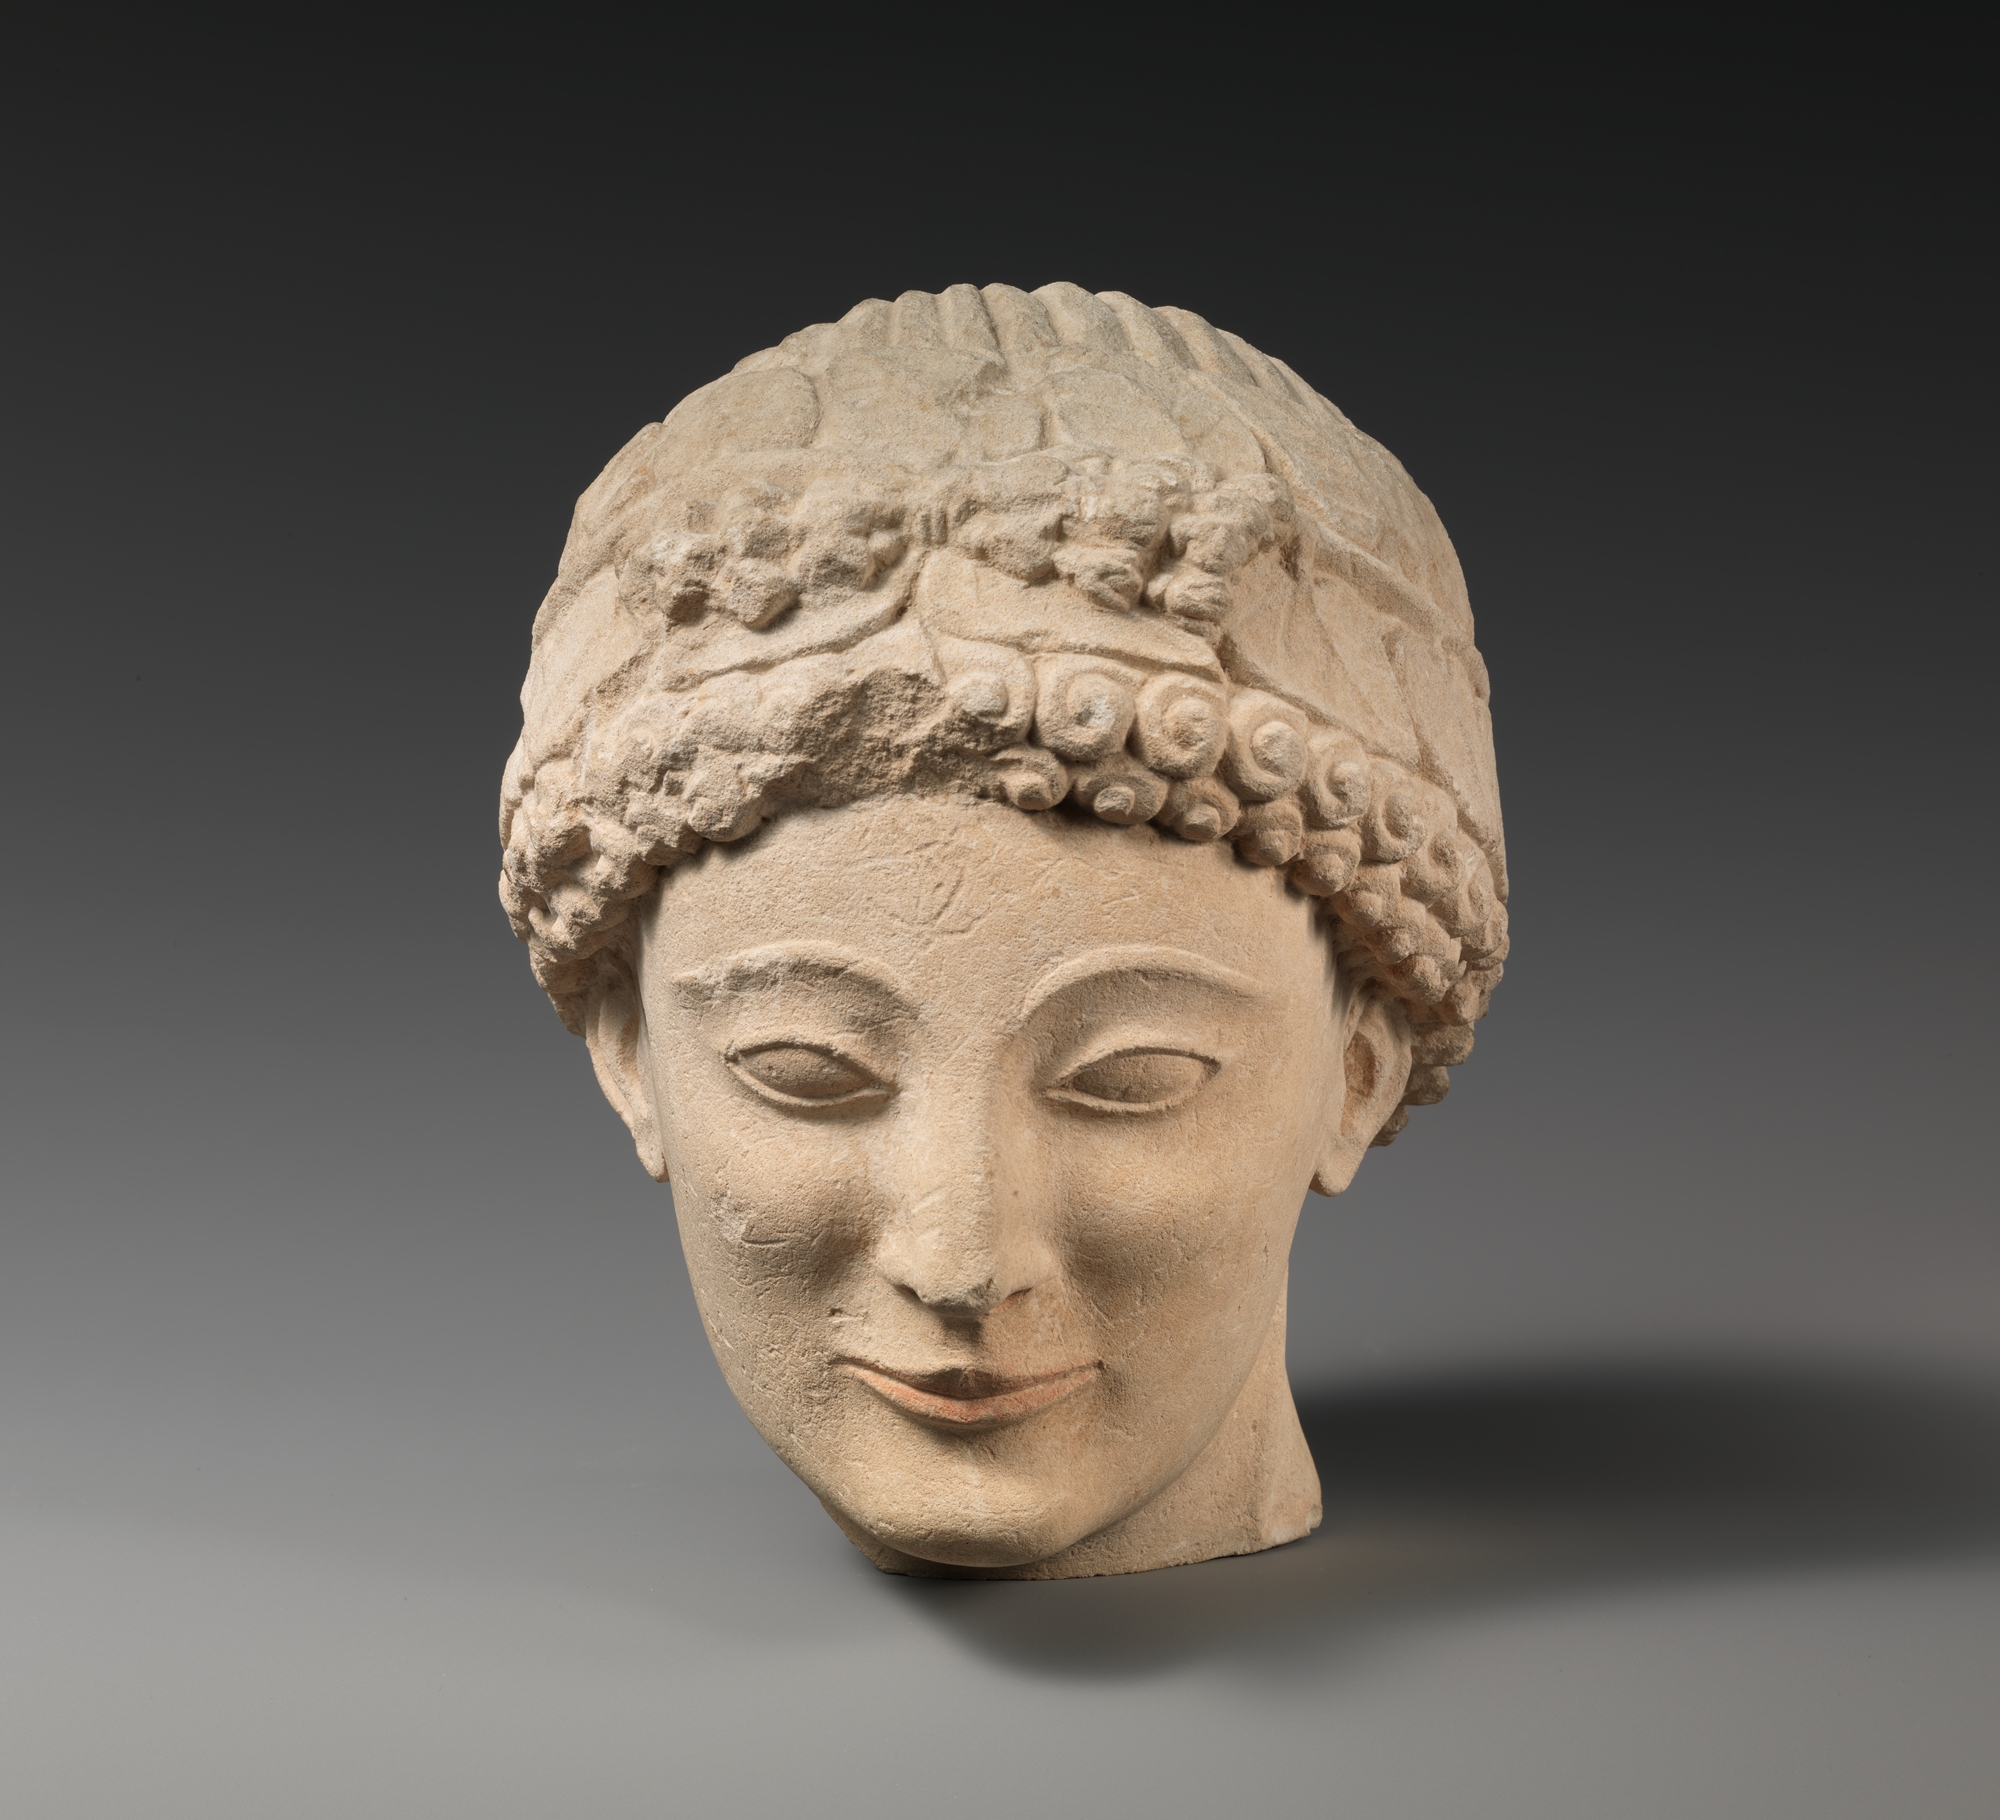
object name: male head, beardless, wearing a wreath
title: Limestone beardless male head with ivy wreath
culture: cypriot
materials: limestone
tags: heads,men,wreaths